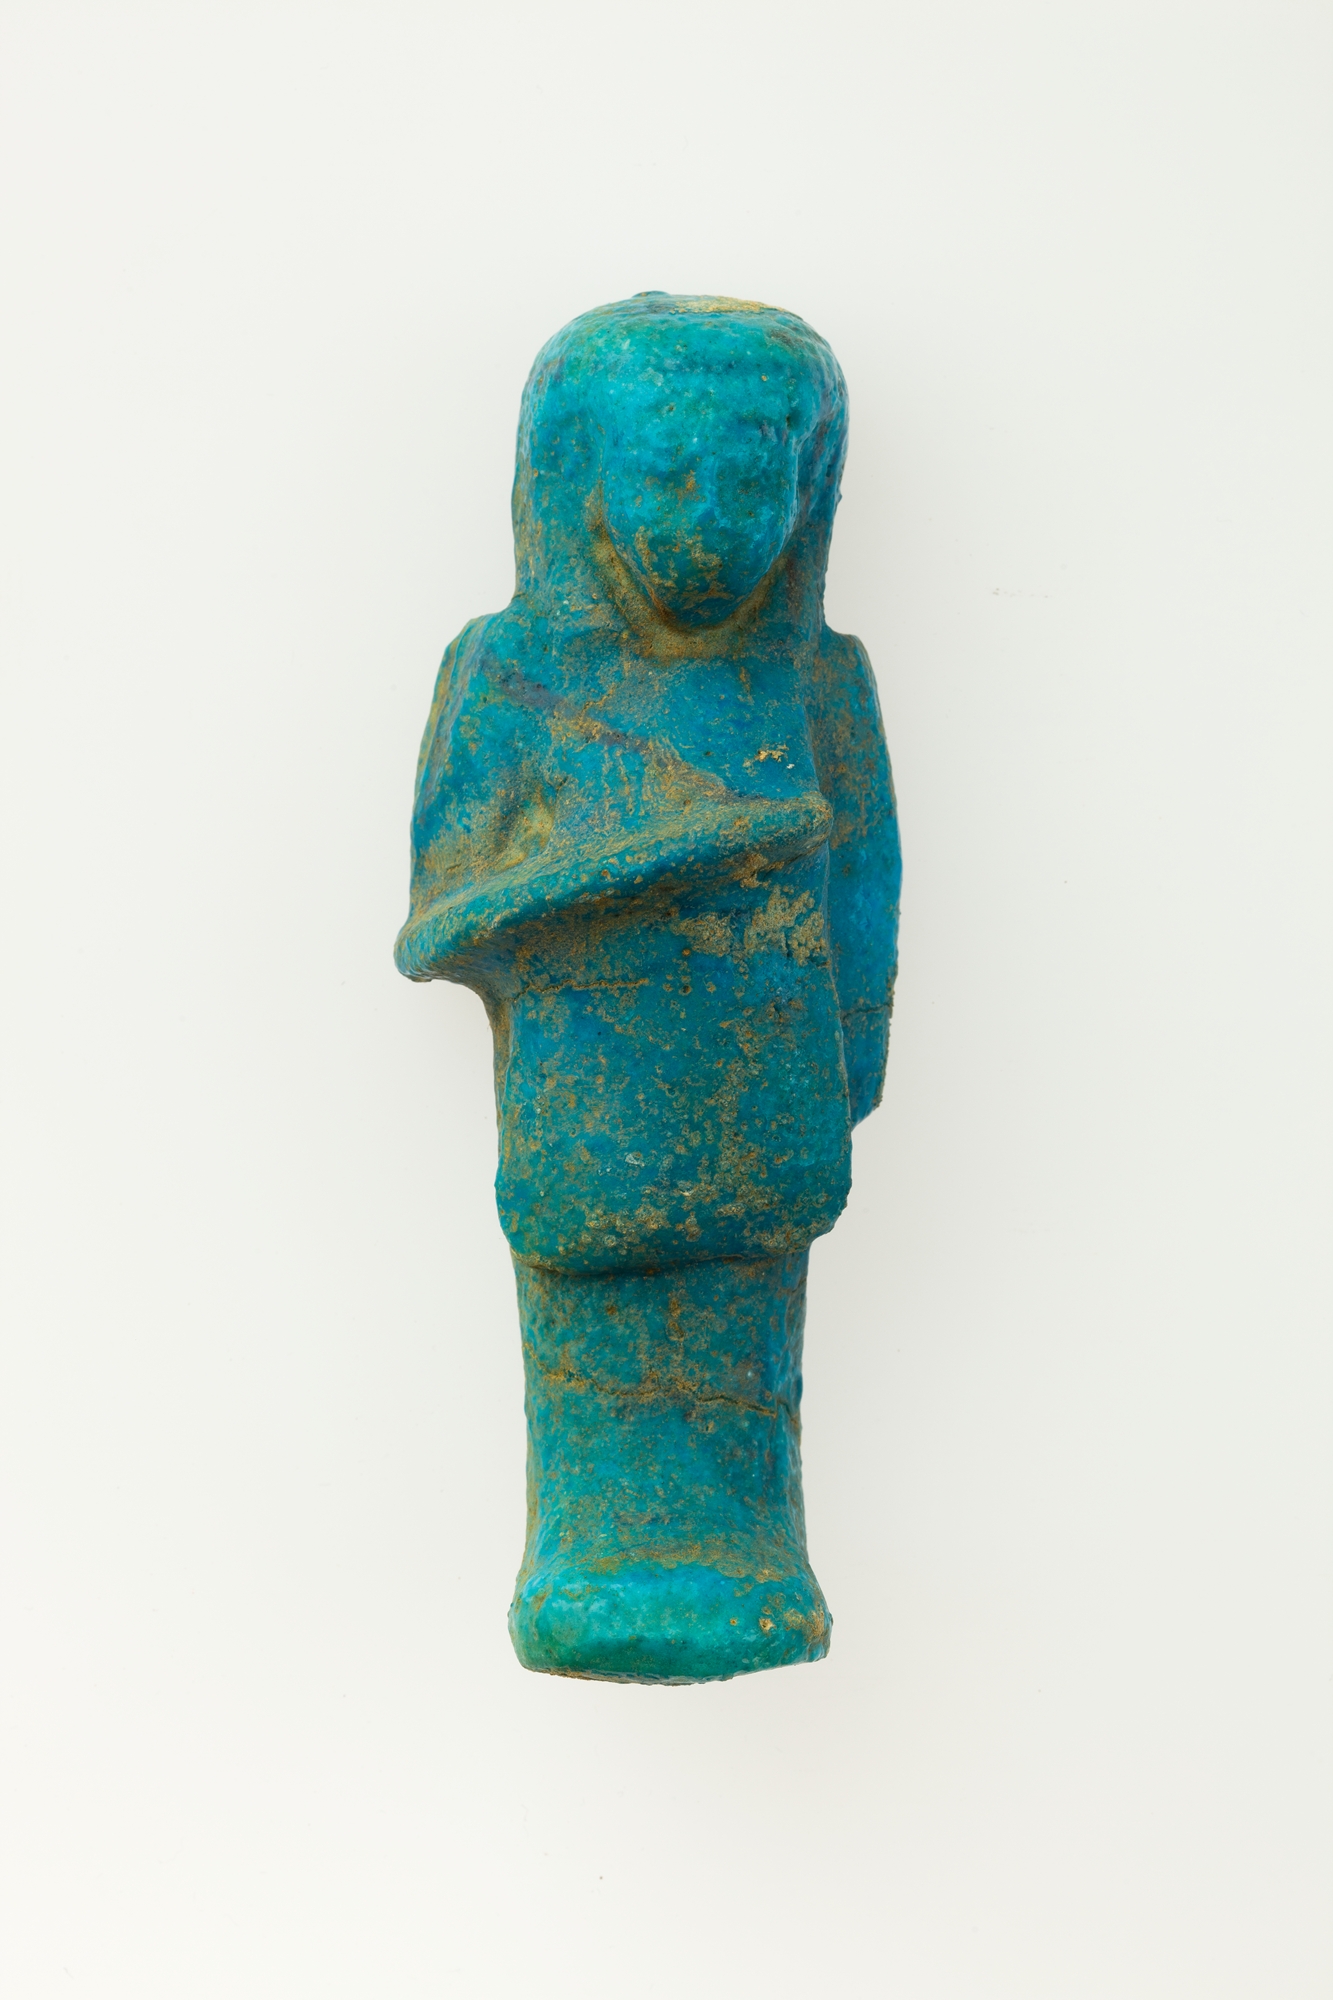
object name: shabti, henettawy c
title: Overseer Shabti of Henettawy (C), Daughter of Isetemkheb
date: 990-970 BCE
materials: faience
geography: egypt